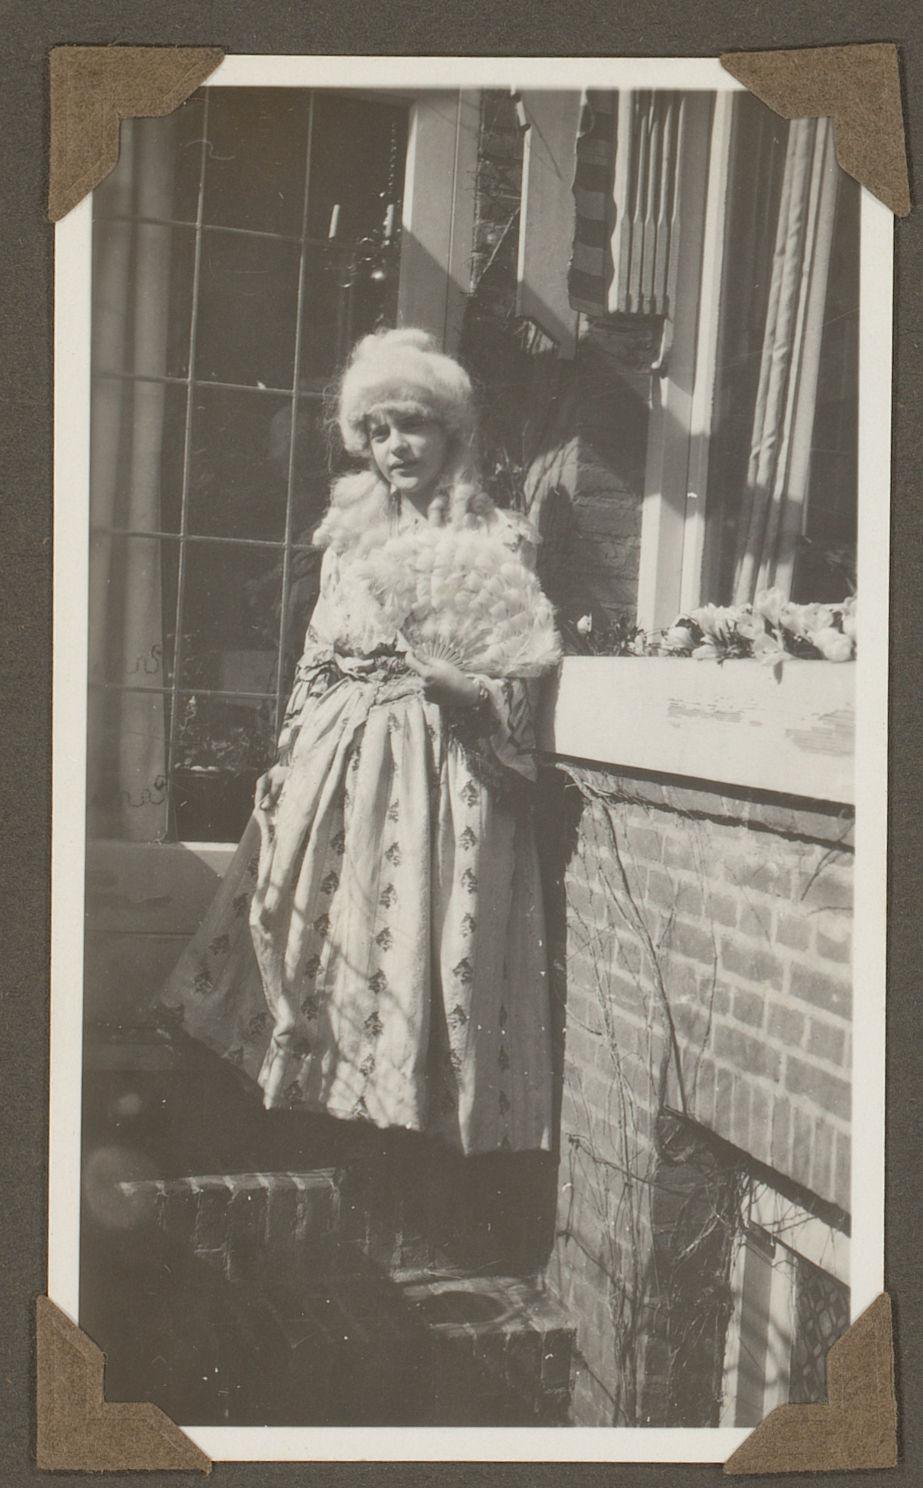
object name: photograph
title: Portret van een meisje met pruik en waaier, staande op een trap voor een huis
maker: Anonymous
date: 1920-1940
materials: photographic support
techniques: gelatin silver print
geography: netherlands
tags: historical persons, fan, girl (child between toddler and youth), wig